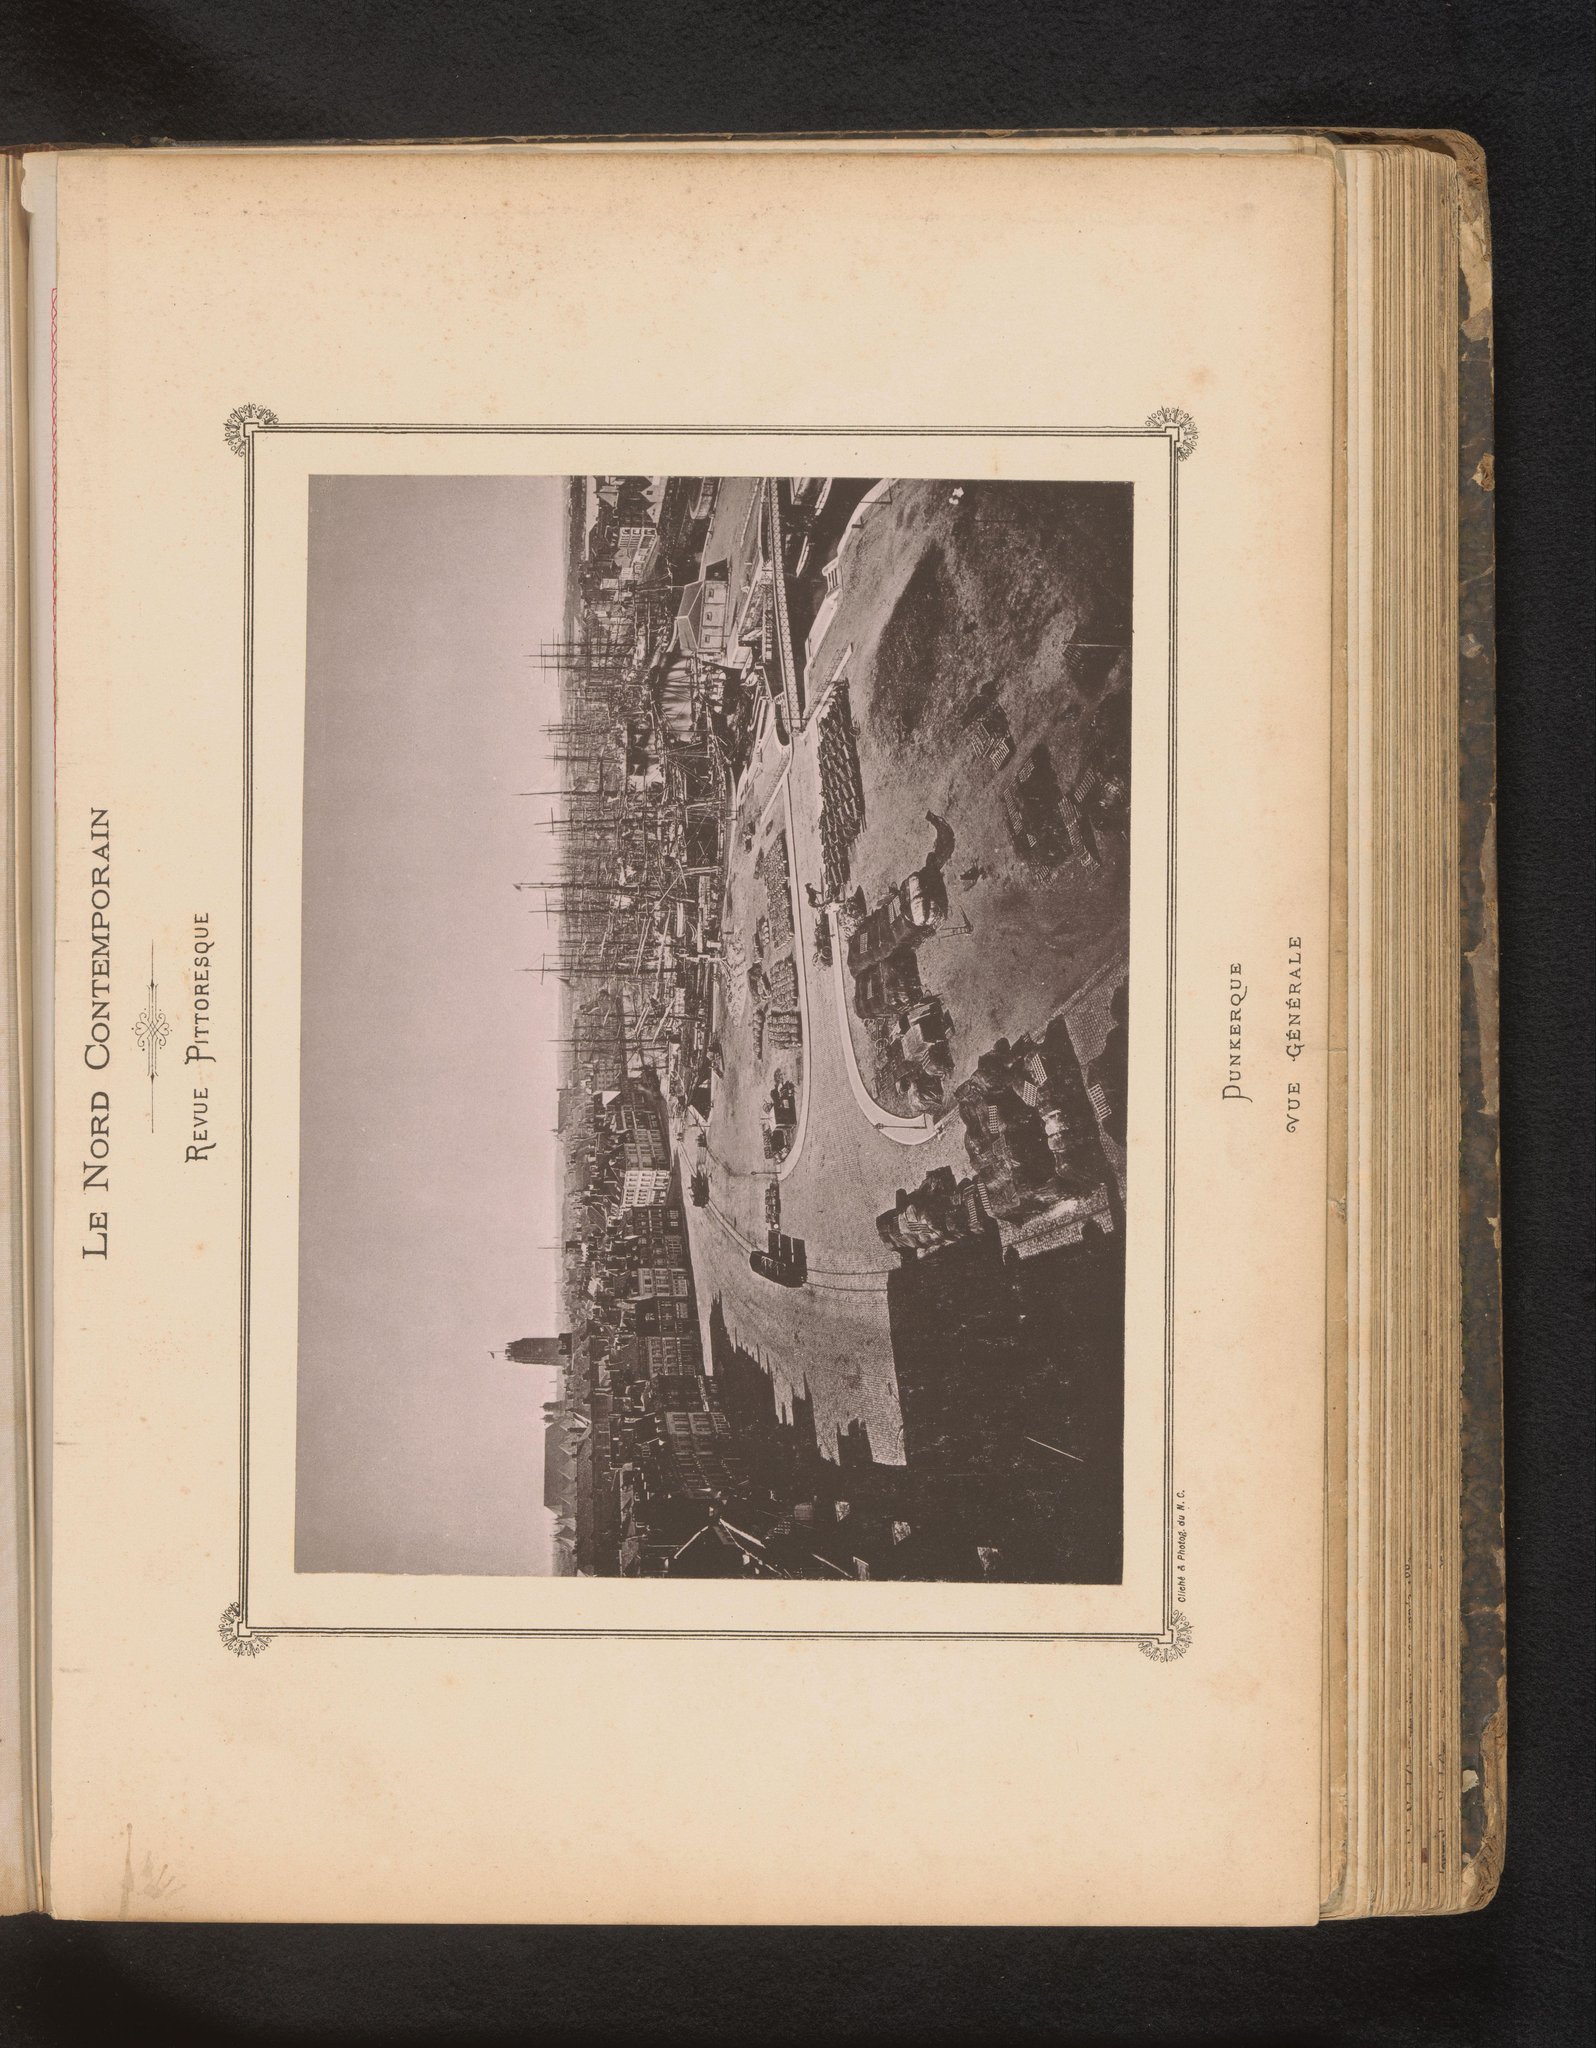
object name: page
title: Dunkerque, Vue Générale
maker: n.c.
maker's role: fotograaf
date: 1878-1883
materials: paper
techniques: photograph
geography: dunkirk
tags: prospect of city, town panorama, silhouette of city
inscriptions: inscription: ‘Le Nord Contemporain/ Revue Pittoresque’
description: Prent op vijfde ongenummerde pagina na pagina 48.